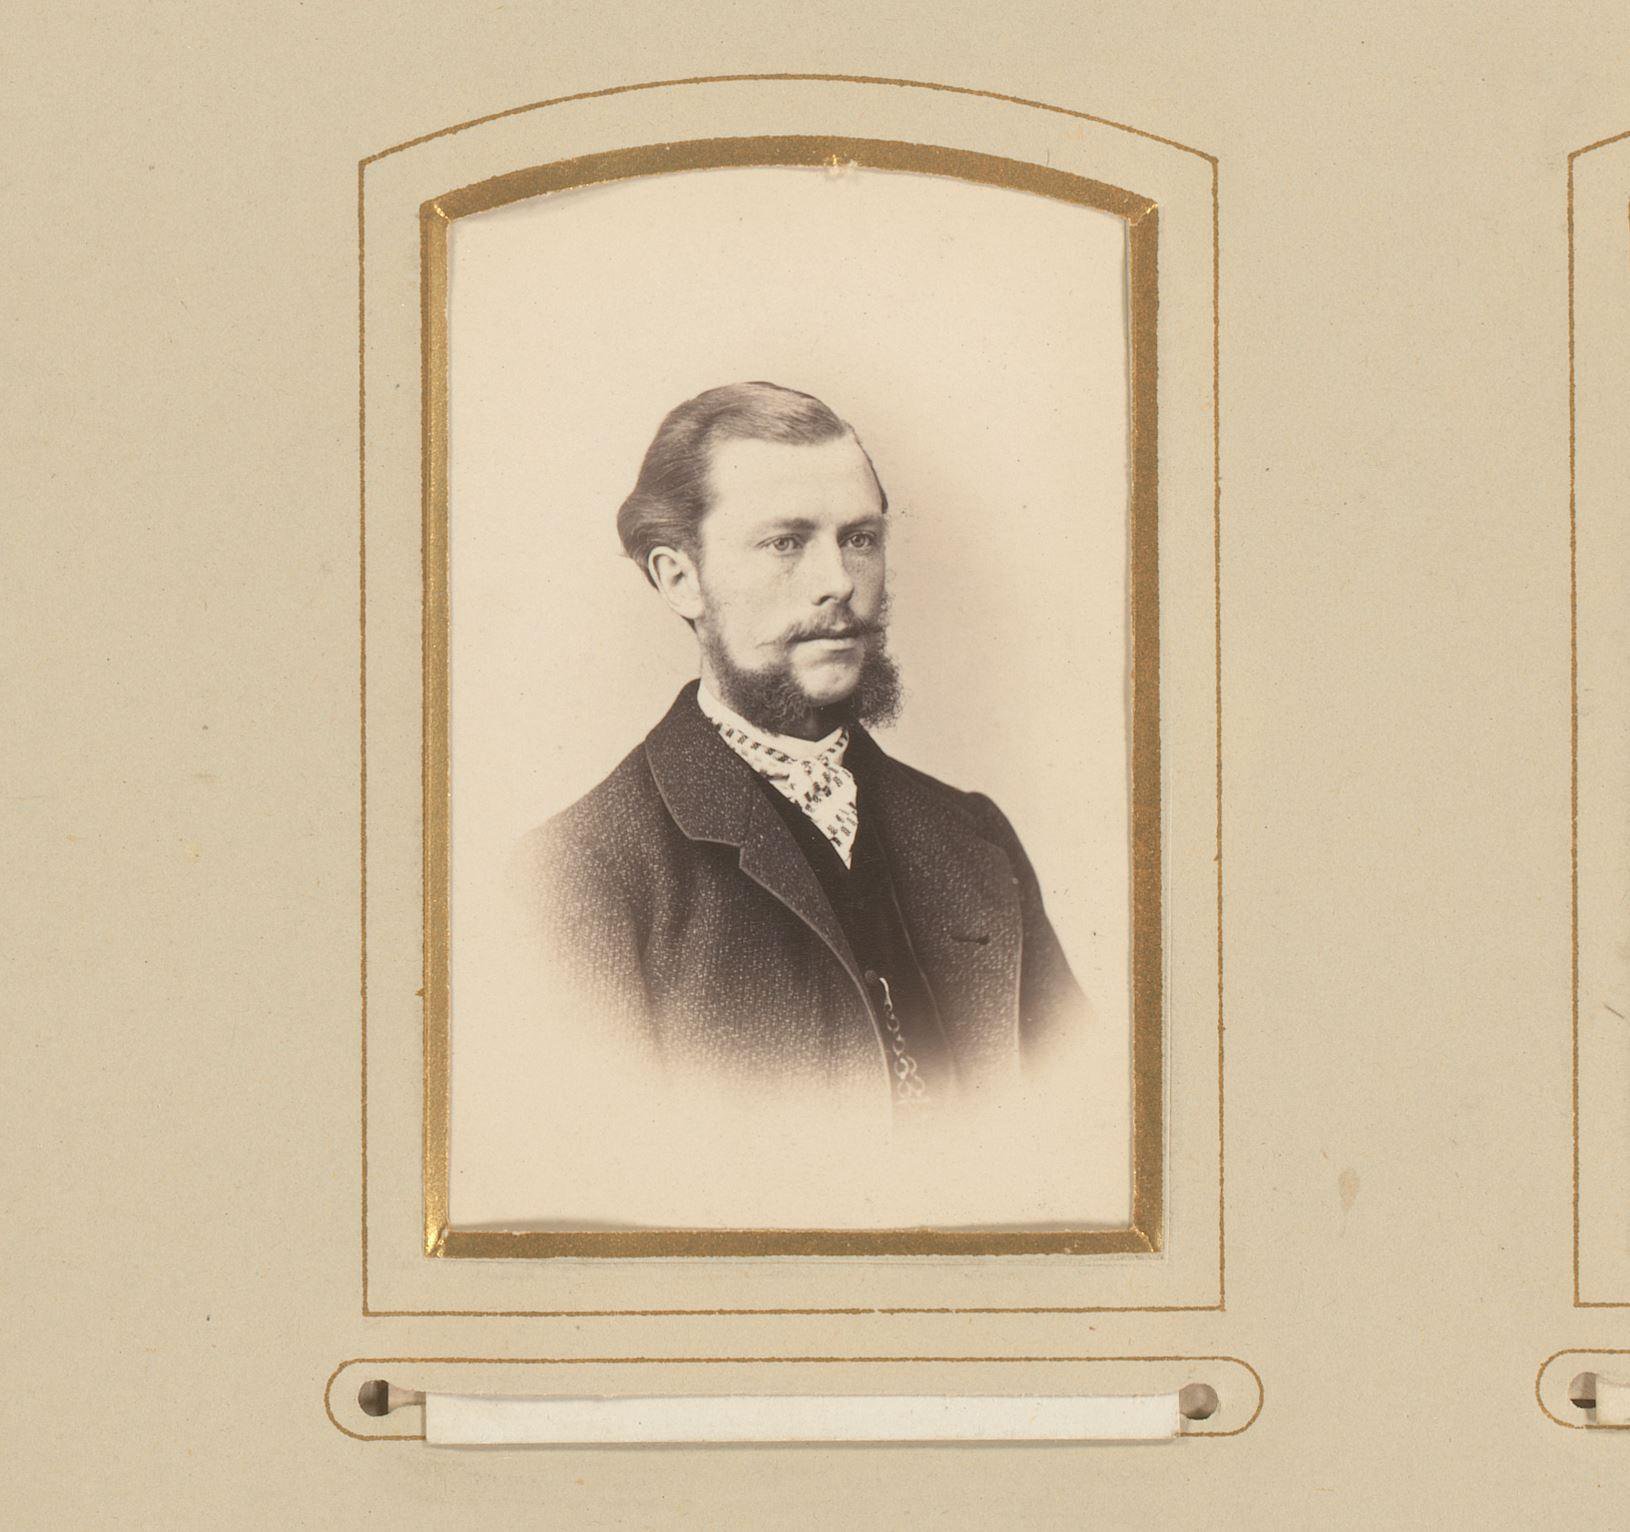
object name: album leaf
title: Portret van een man met snor en baard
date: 1864-1868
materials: cardboard, photographic support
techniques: albumen print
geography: berlin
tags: moustache, historical persons, beard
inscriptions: inscription: ‘Photographische Gesellschaft/ BERLIN/ am Dönhofsplatz./ Abtheilung für Portraits/ von/ GEBRÜDER GRUNDNER.’